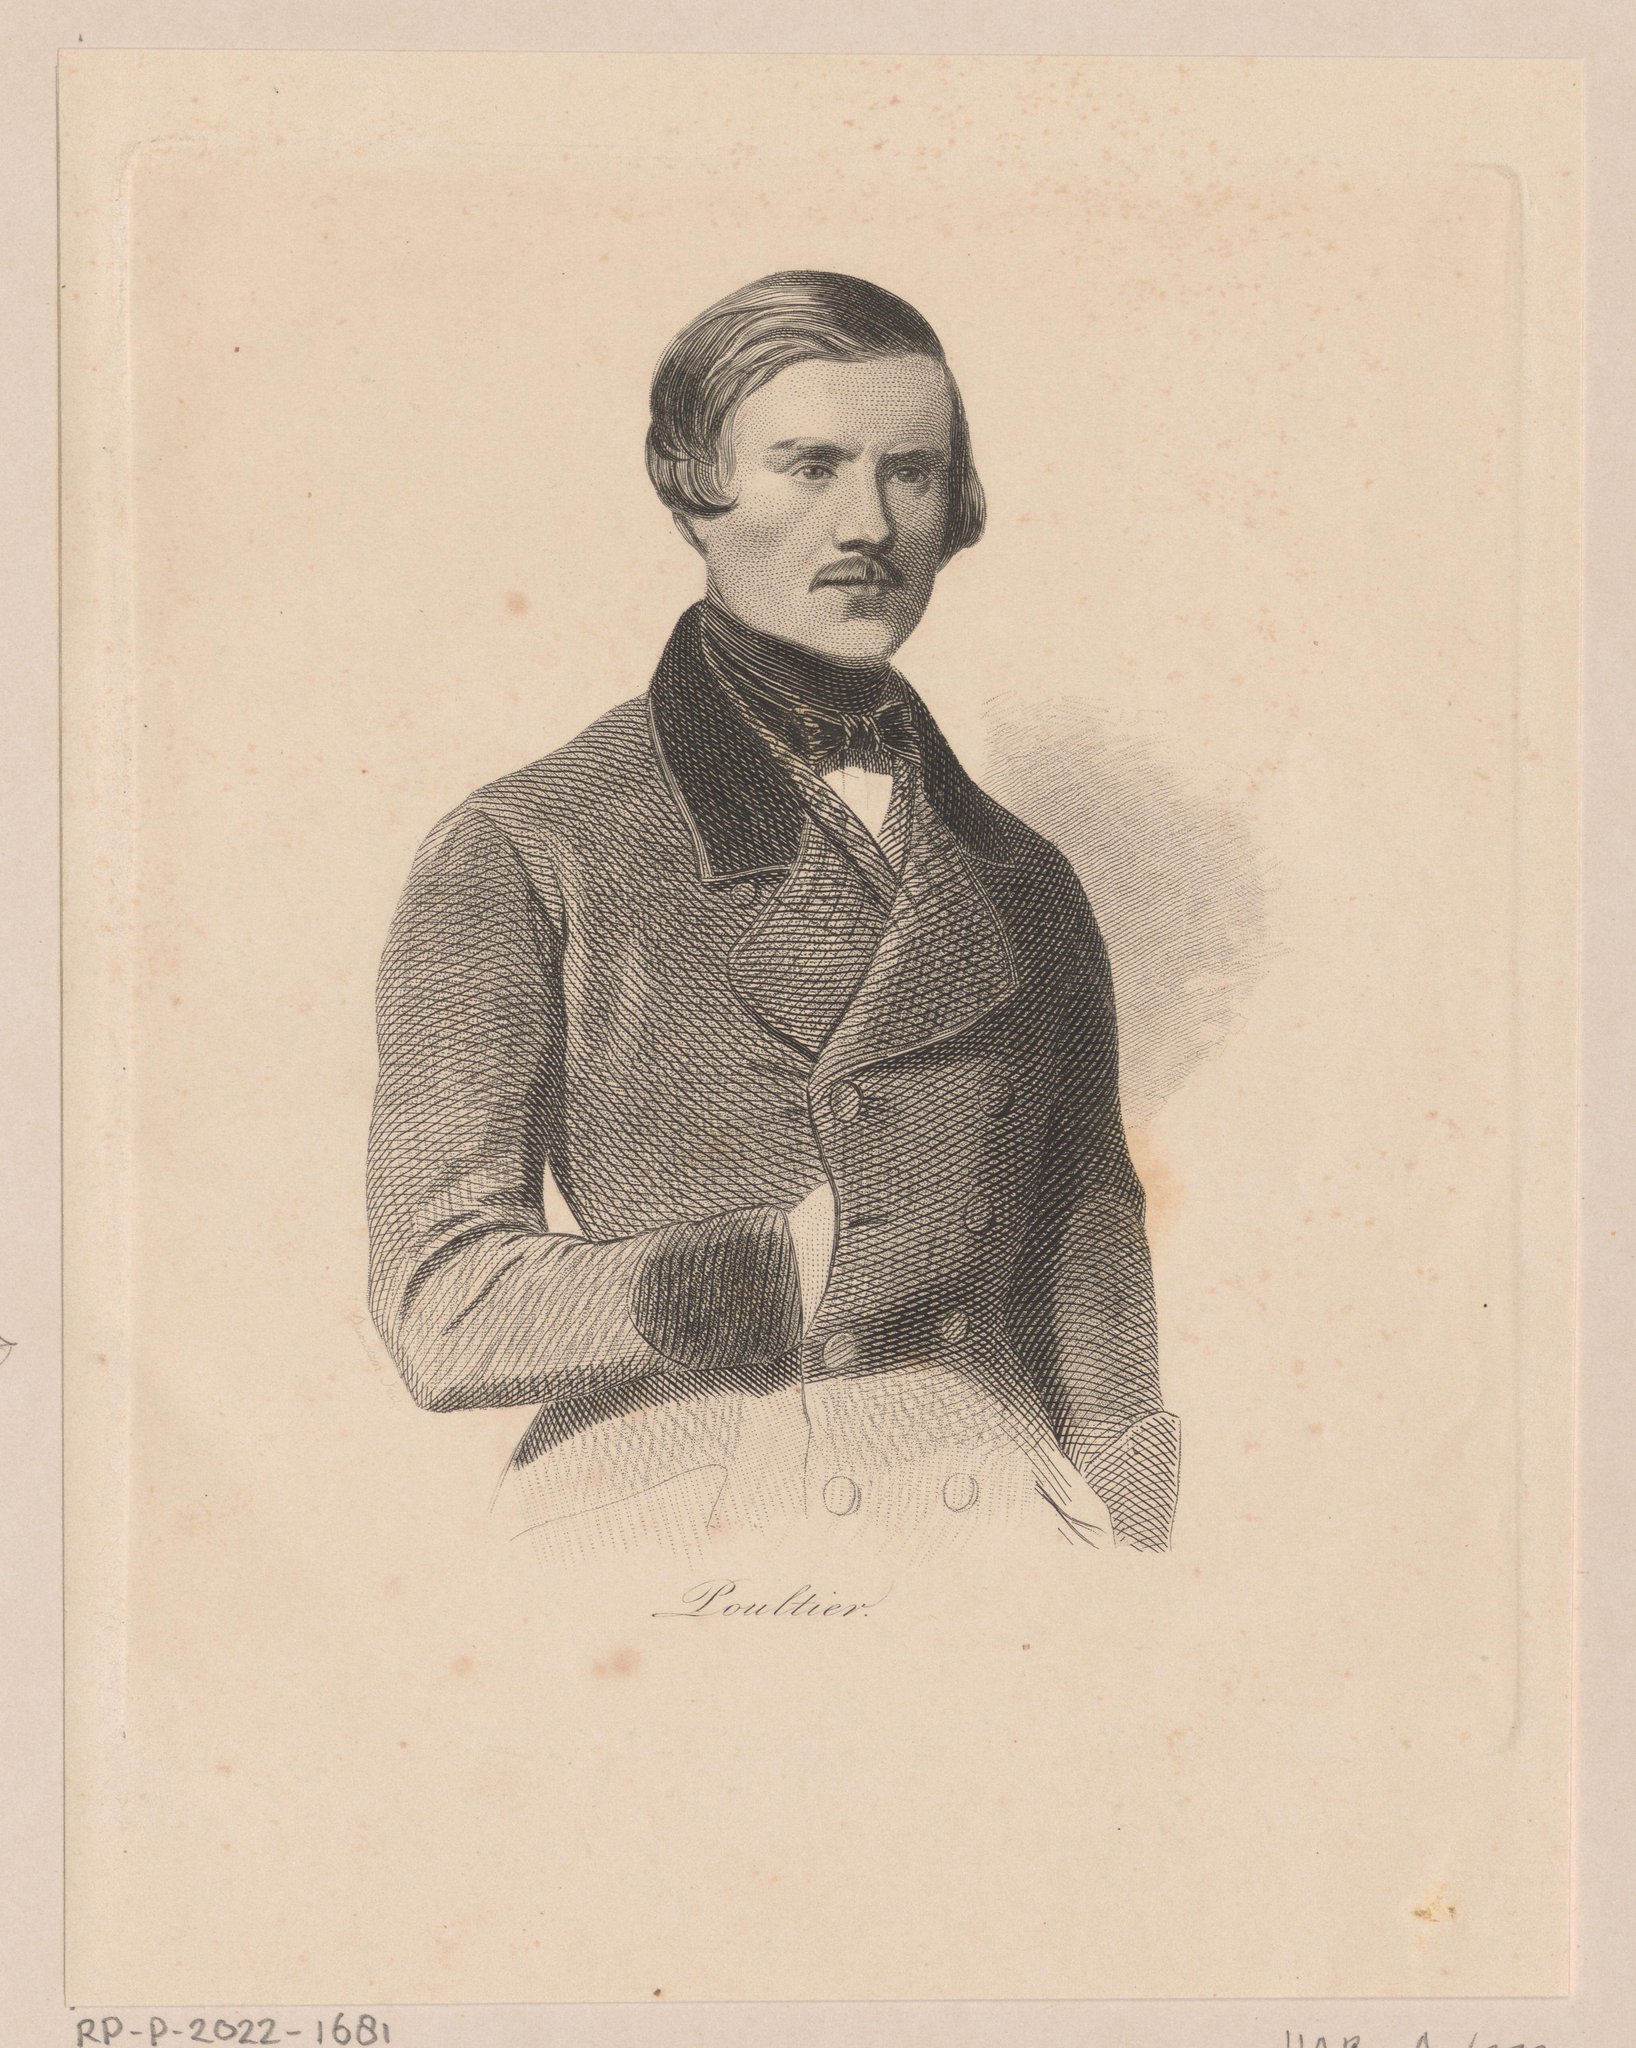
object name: print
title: Portret van Placide-Alexandre-Guillaume Poultier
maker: Anonymous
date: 1844-1899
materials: paper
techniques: etching, roulette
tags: historical persons, opera-singer (male)